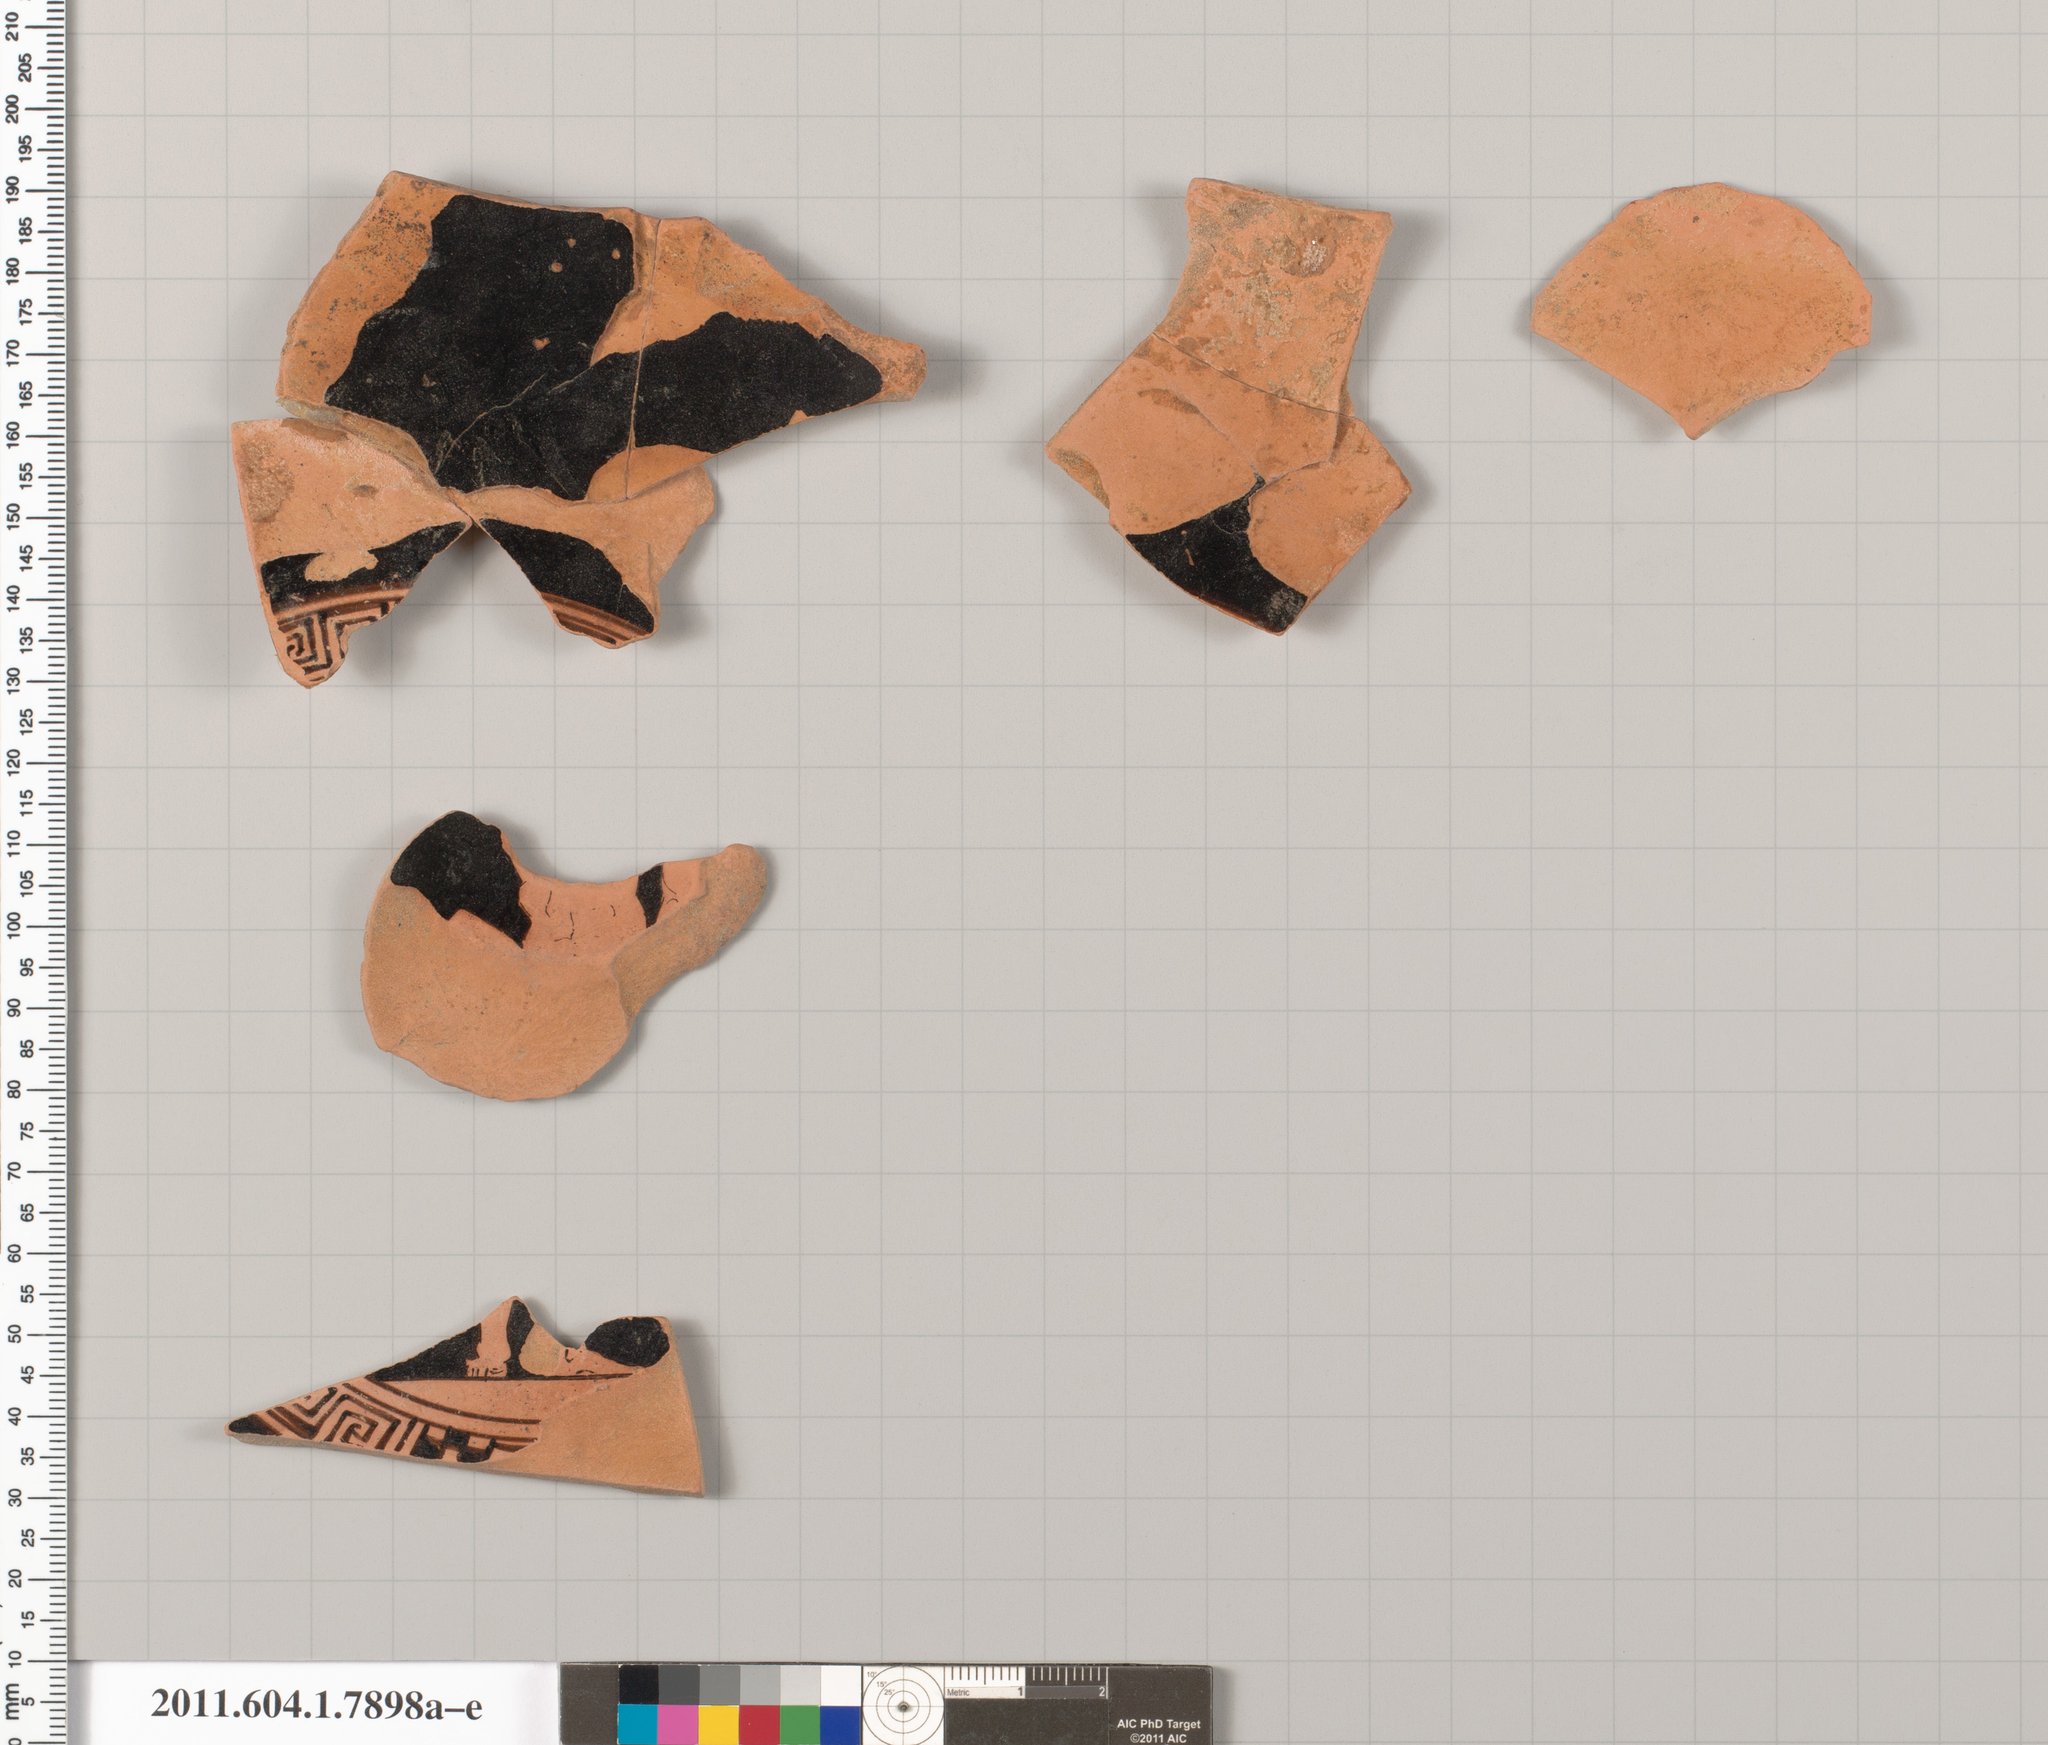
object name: kylix fragment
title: Terracotta fragments of a kylix (drinking cup)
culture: greek, attic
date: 450 BCE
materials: terracotta